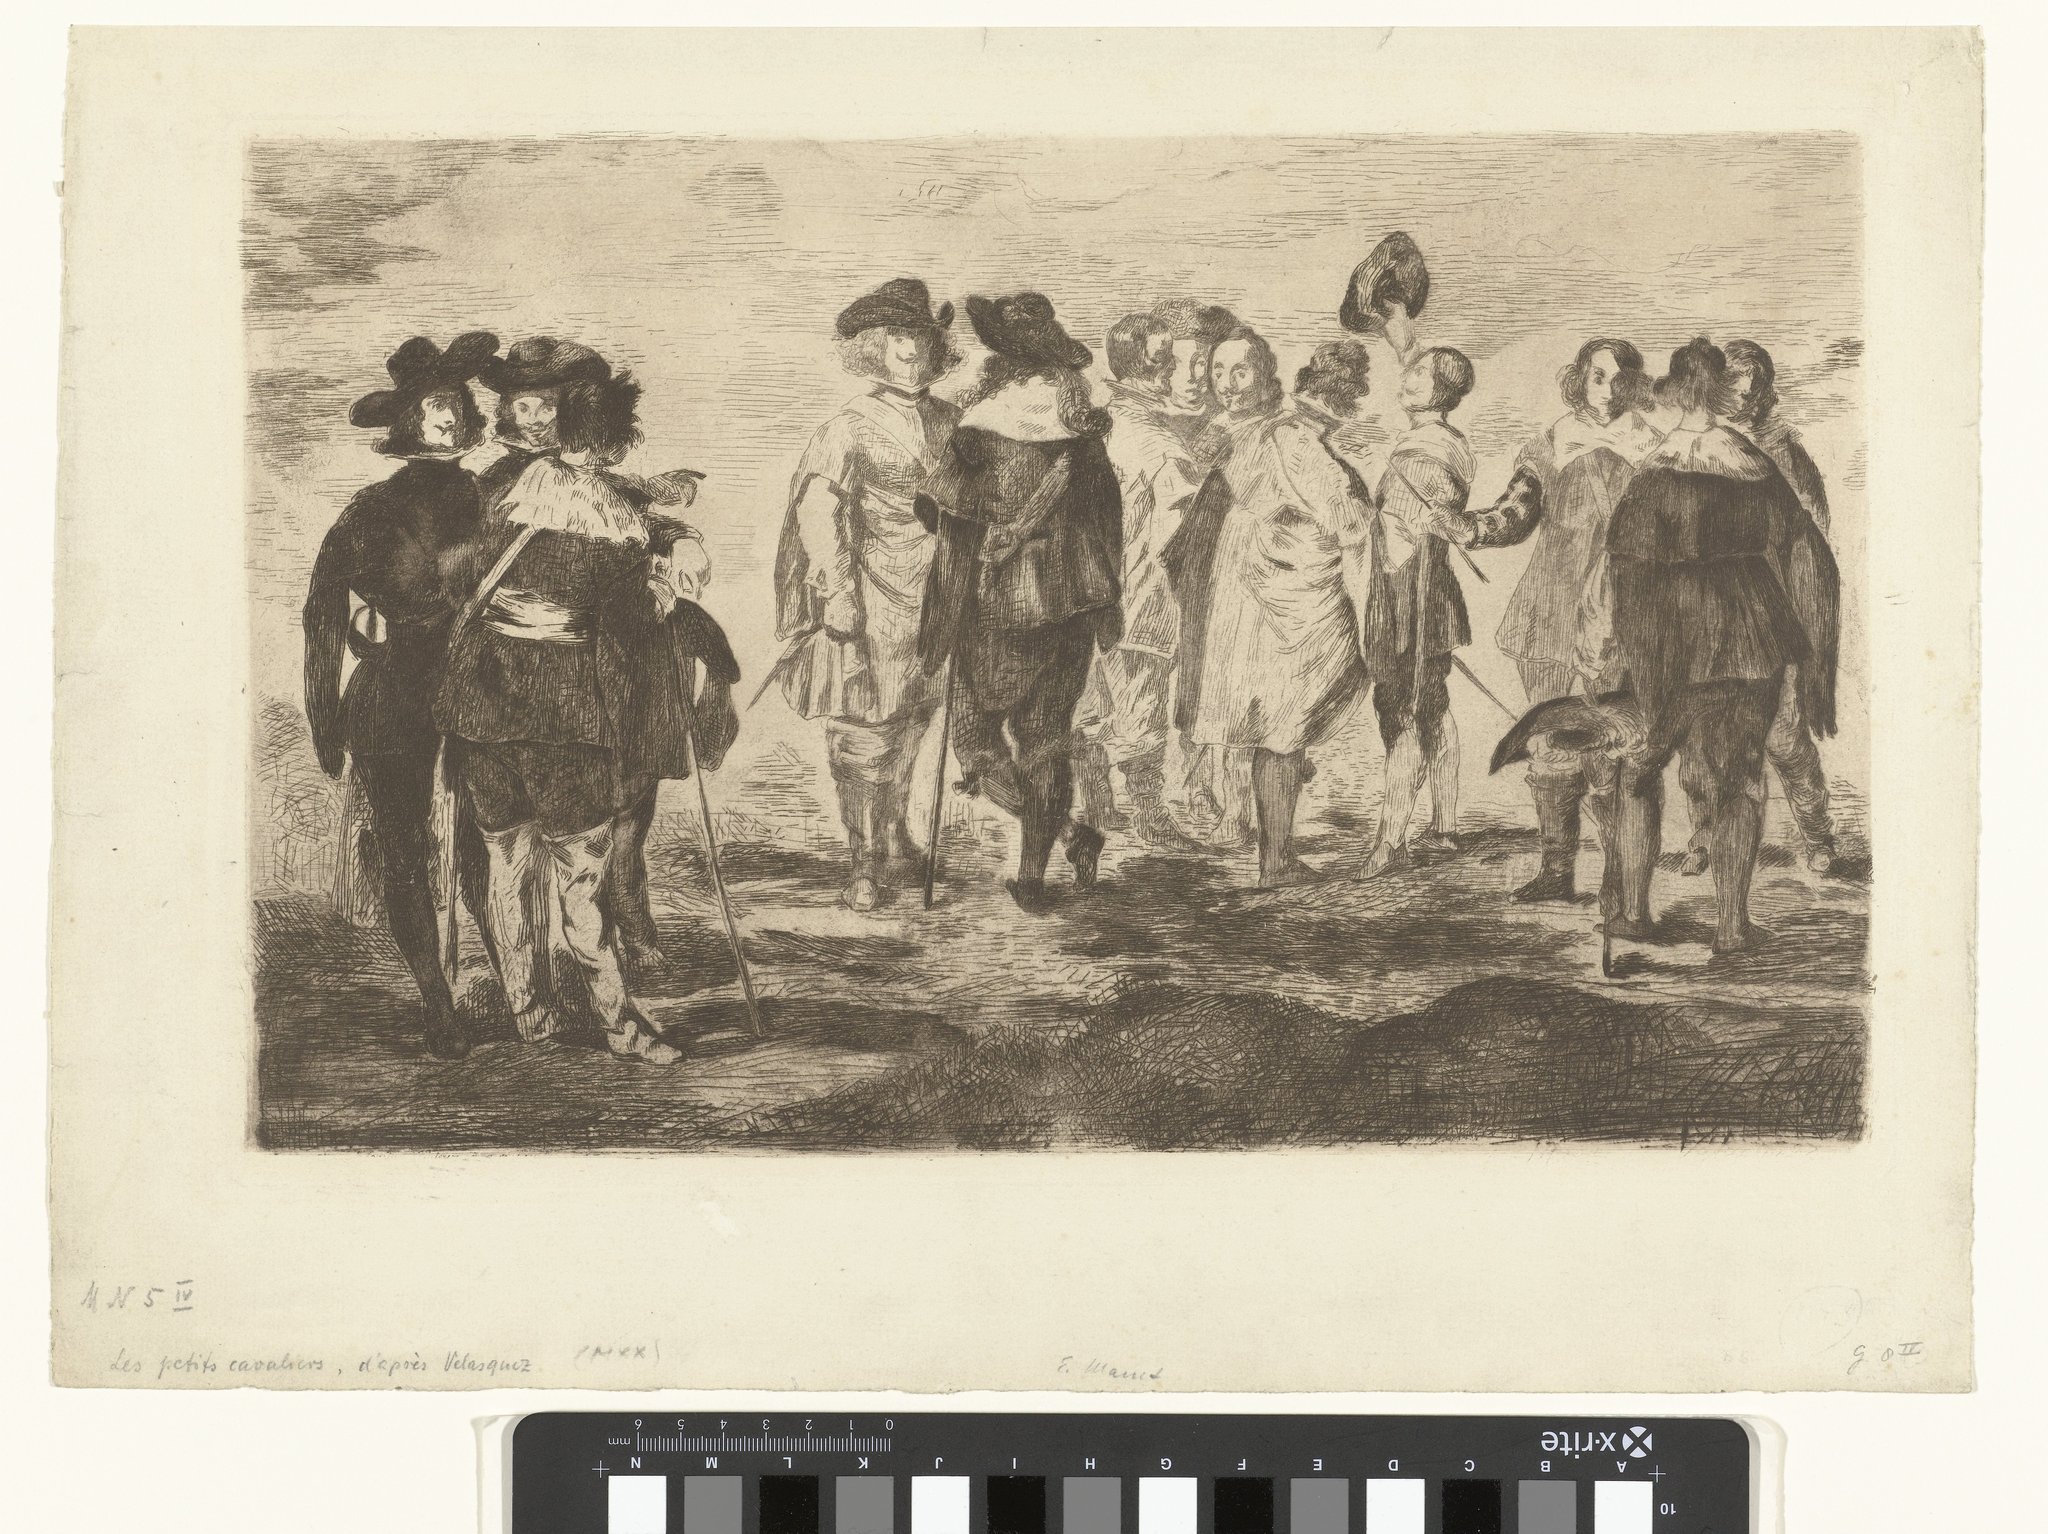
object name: print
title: Groep ruiters met elkaar in gesprek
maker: edouard manet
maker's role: painter, print maker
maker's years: 1832-1883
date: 1860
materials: paper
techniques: aquatint, drypoint, etching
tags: warfare; military affairs (+ cavalry, horsemen)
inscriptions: collector's mark: Lugt 2228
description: Een groep mannen of ruiters staat zonder paarden in kleine groepjes bij elkaar. Uit verschillende armgebaren kan worden opgemaakt dat ze gesprekken voeren.